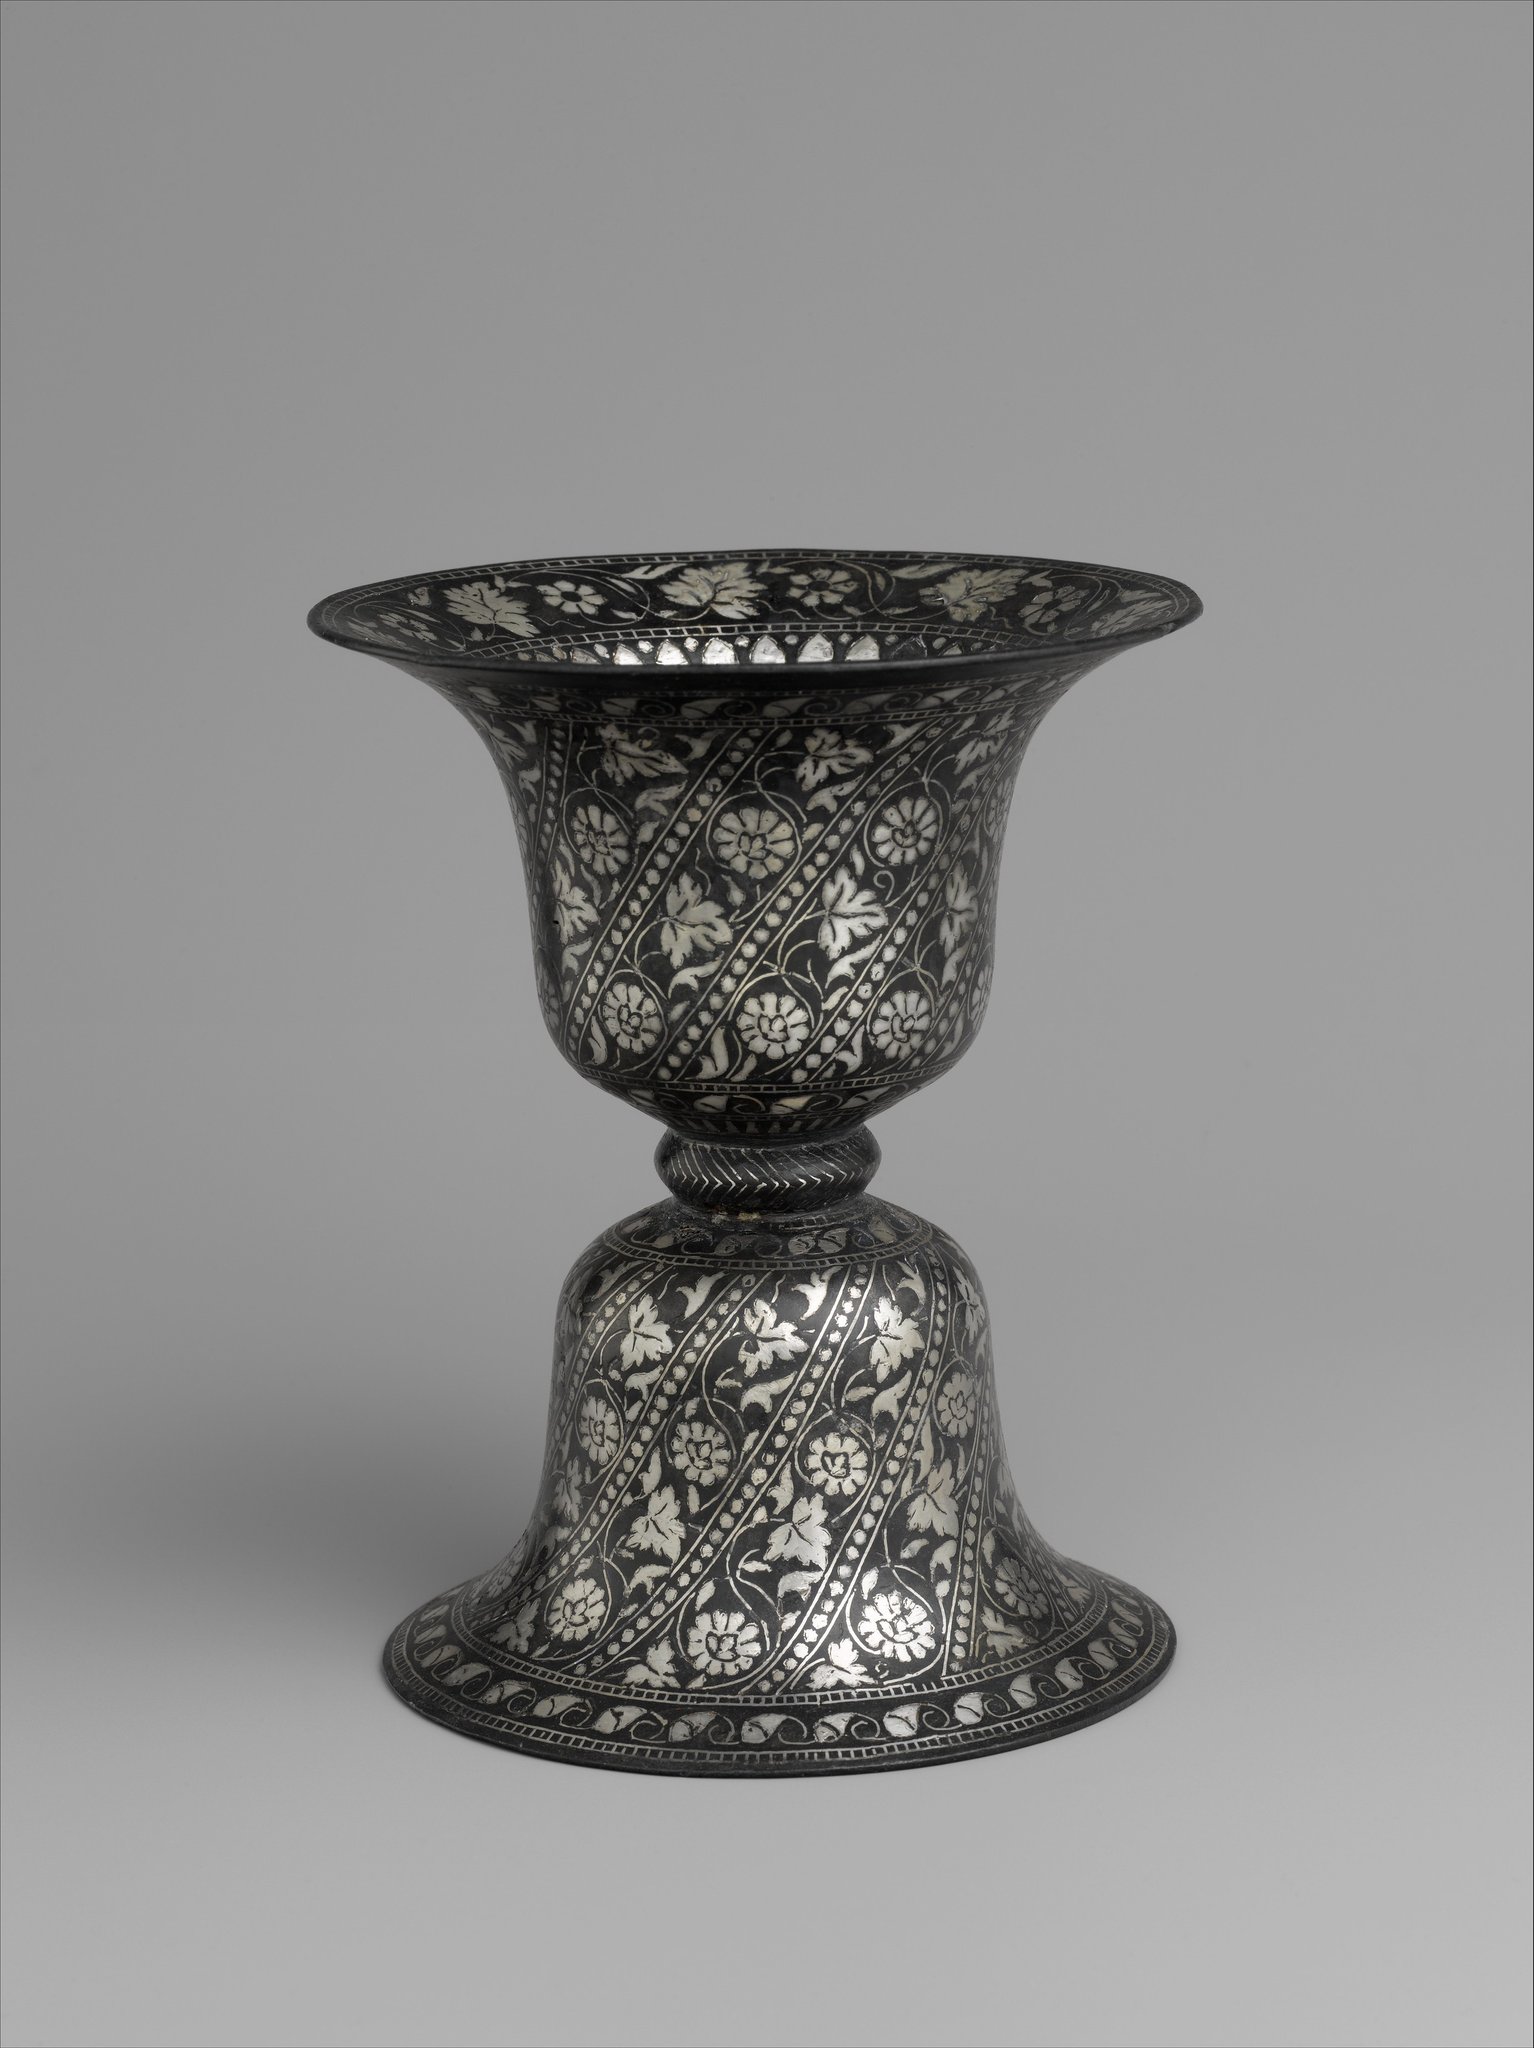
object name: spittoon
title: Spittoon in Double Bell Design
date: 1767-1833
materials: copper alloy, silver, zinc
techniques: casting, engraving, inlay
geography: india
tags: flowers